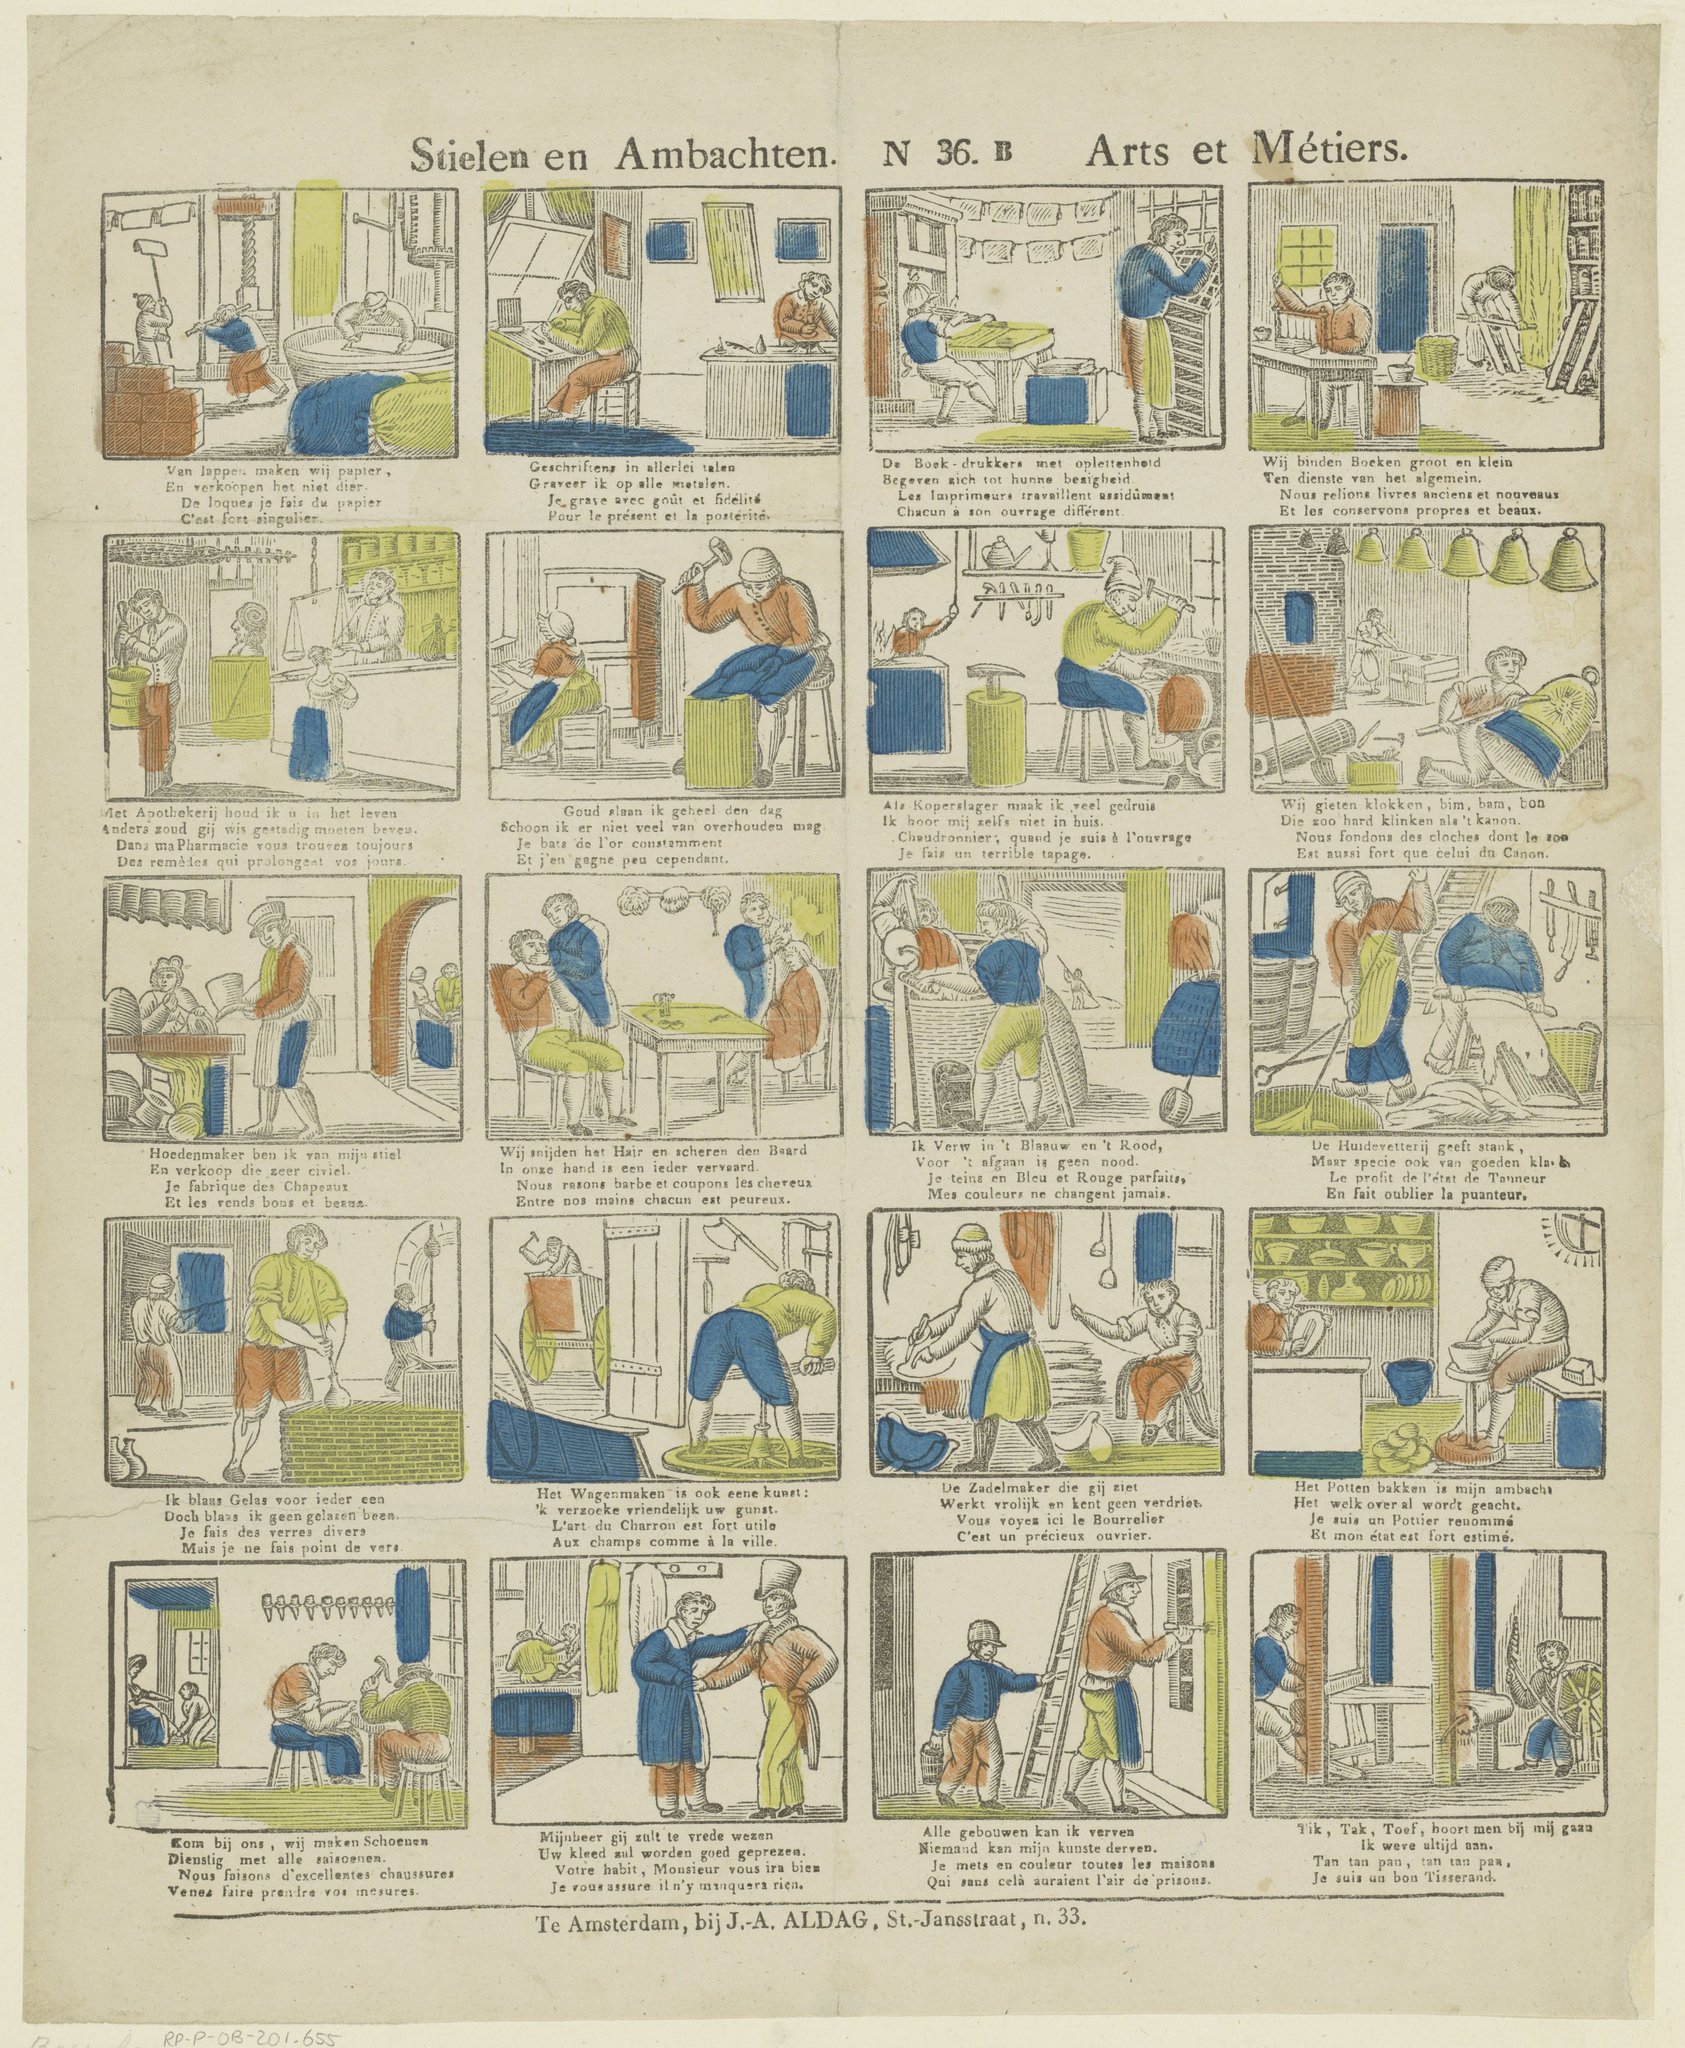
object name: print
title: Stielen en Ambachten / Arts et Métiers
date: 1800-1833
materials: paper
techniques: colour, letterpress printing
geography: amsterdam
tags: craft-production, skilled handiwork, pharmacist, druggist, apothecary; pharmacy, drugstore, dispensing chemist, painter at work, in his studio - cc - out of doors, crafts and industries, potter, ceramist, shoe-maker, cobbler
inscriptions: collector's mark: Lugt 2760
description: Blad met 20 voorstellingen van ambachtslieden en beroepen, zoals papiermaker, koperslager, barbier en schilder. Onder elke afbeelding een tweeregelig vers in het Nederlands of in het Frans. Genummerd midden boven: N 36. B.